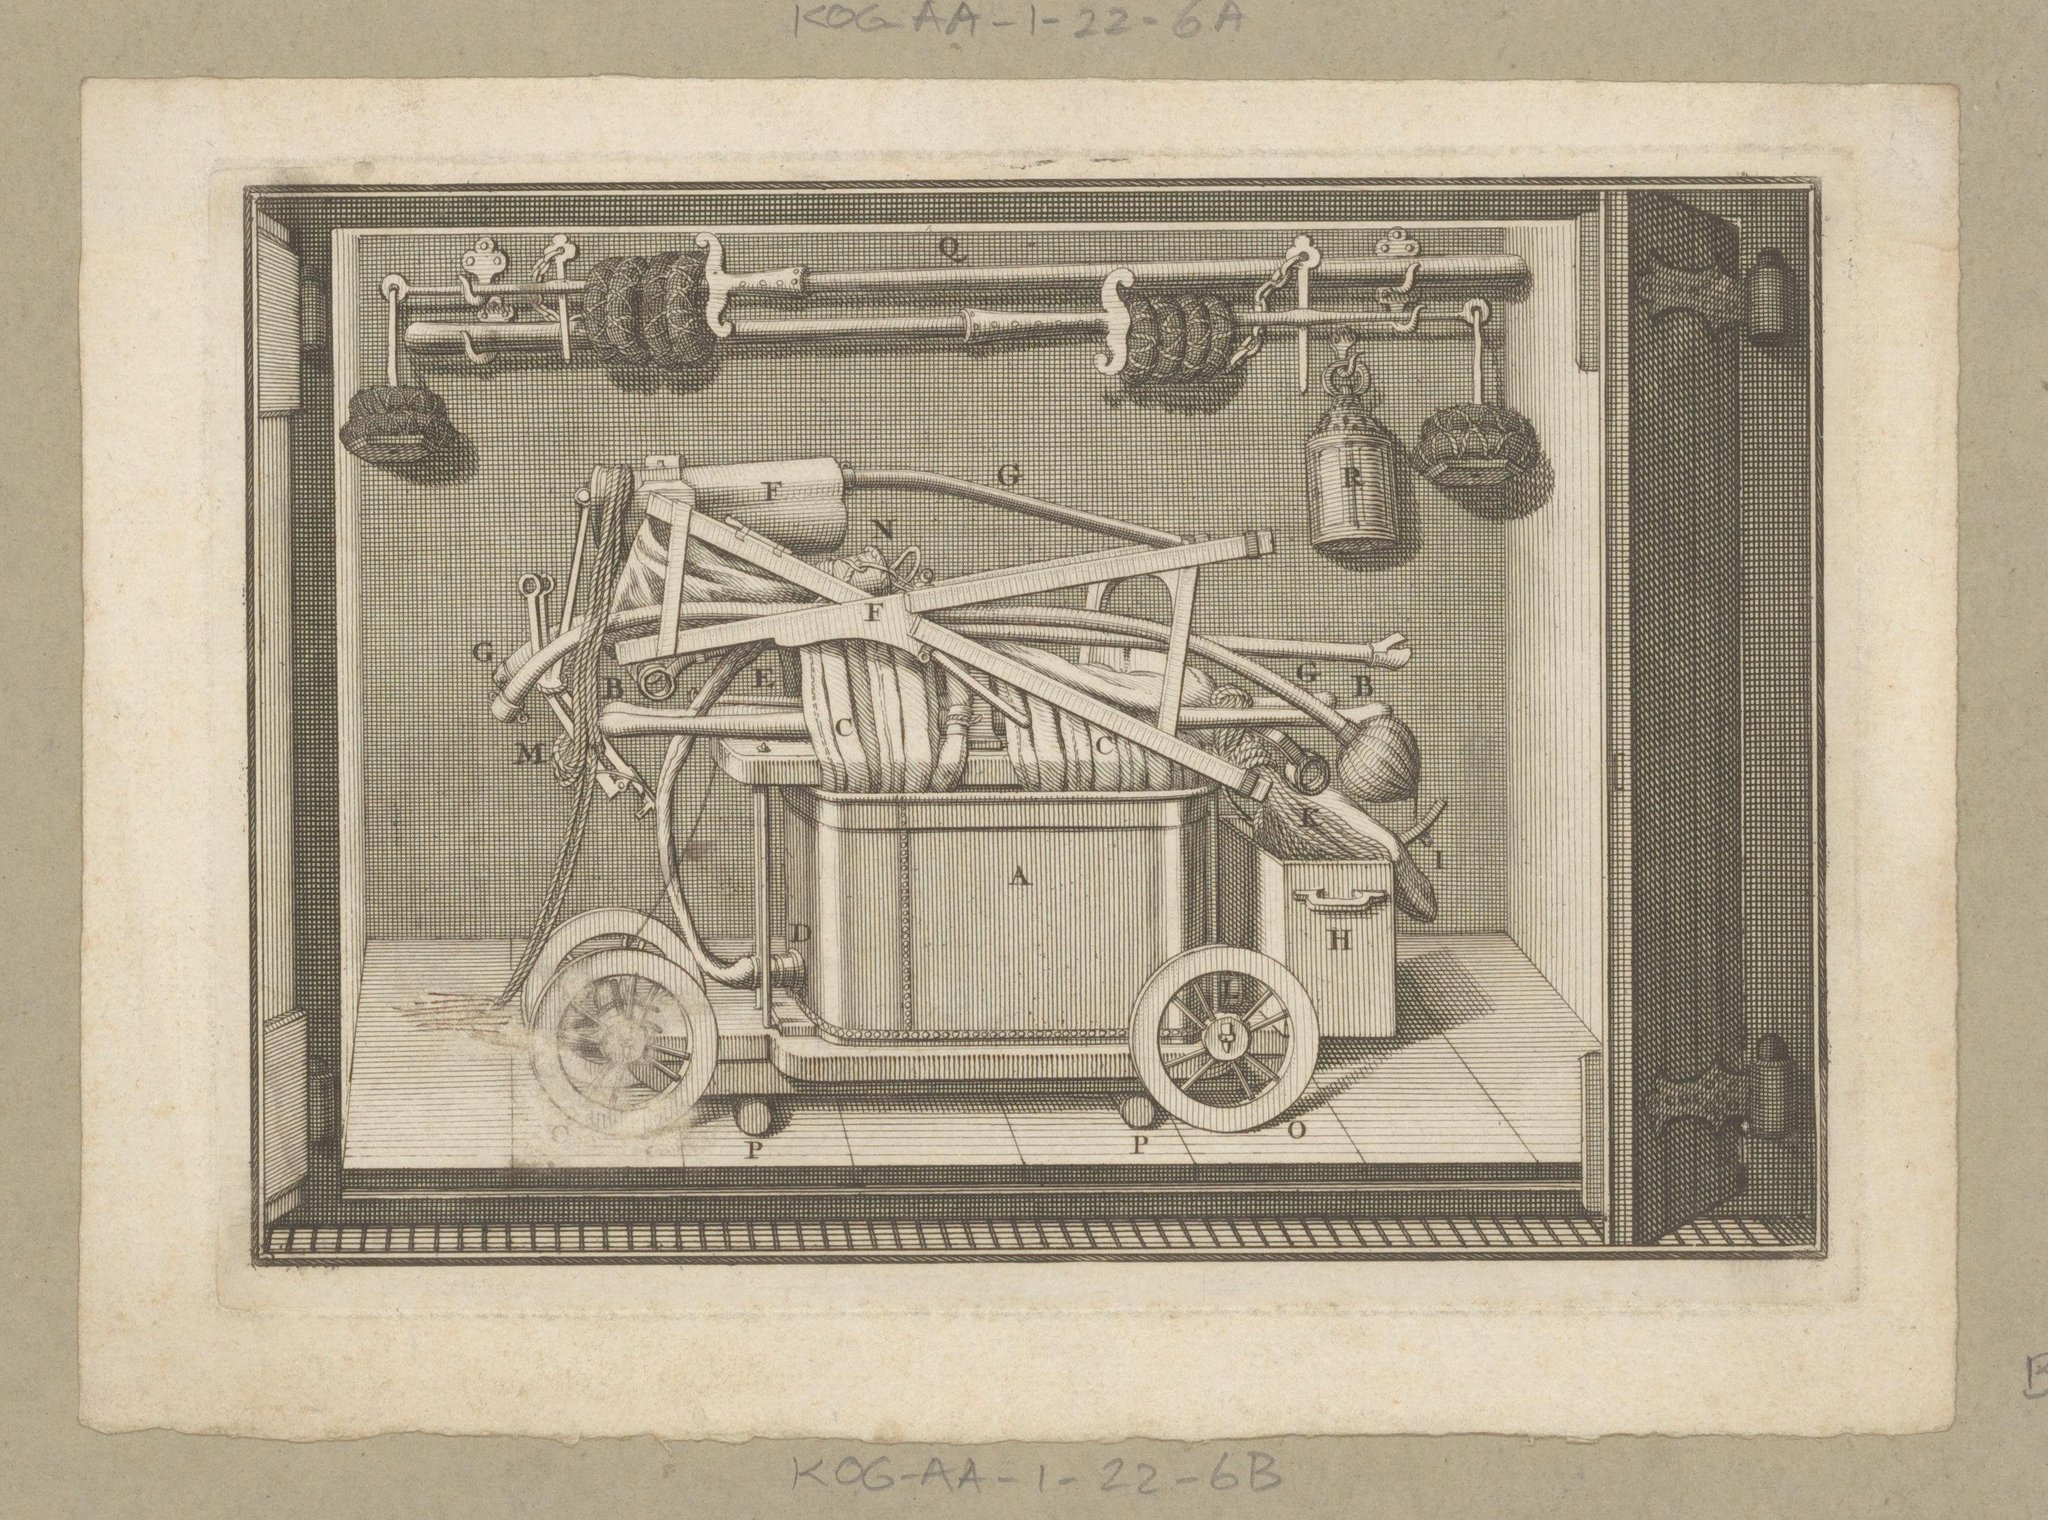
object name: print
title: Slangbrandspuit en pomp opgeborgen in een brandspuithuis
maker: Anonymous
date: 1677-1750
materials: paper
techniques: etching, pen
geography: northern netherlands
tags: amsterdam, print maker, draughtsman, jan van der heyden, fire-hose, fire-extinguishing equipment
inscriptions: collector's mark: Lugt 1641b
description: Een eerste keer samen met de bijbehorende instructie uitgegeven door Jan van der Heyden en diens zoon Samuel van der Heyden tussen 1677, wanneer het octrooi voor de slangbrandspuit verworven wordt, en 1712, wanneer Jan van der Heyden sterft. Vervolgens een tweede keer gedrukt door Wybrand en Arend Almenum, beiden generale brandmeester te Amsterdam, en ten slotte nog een derde keer door de erven van Arend Almenum. Ondertussen of daarna nogmaals als op zichzelf staande prent gedrukt. Bijprent niet gebruikt in de uitgaven van Jan van der Heydens Brandspuitenboek.